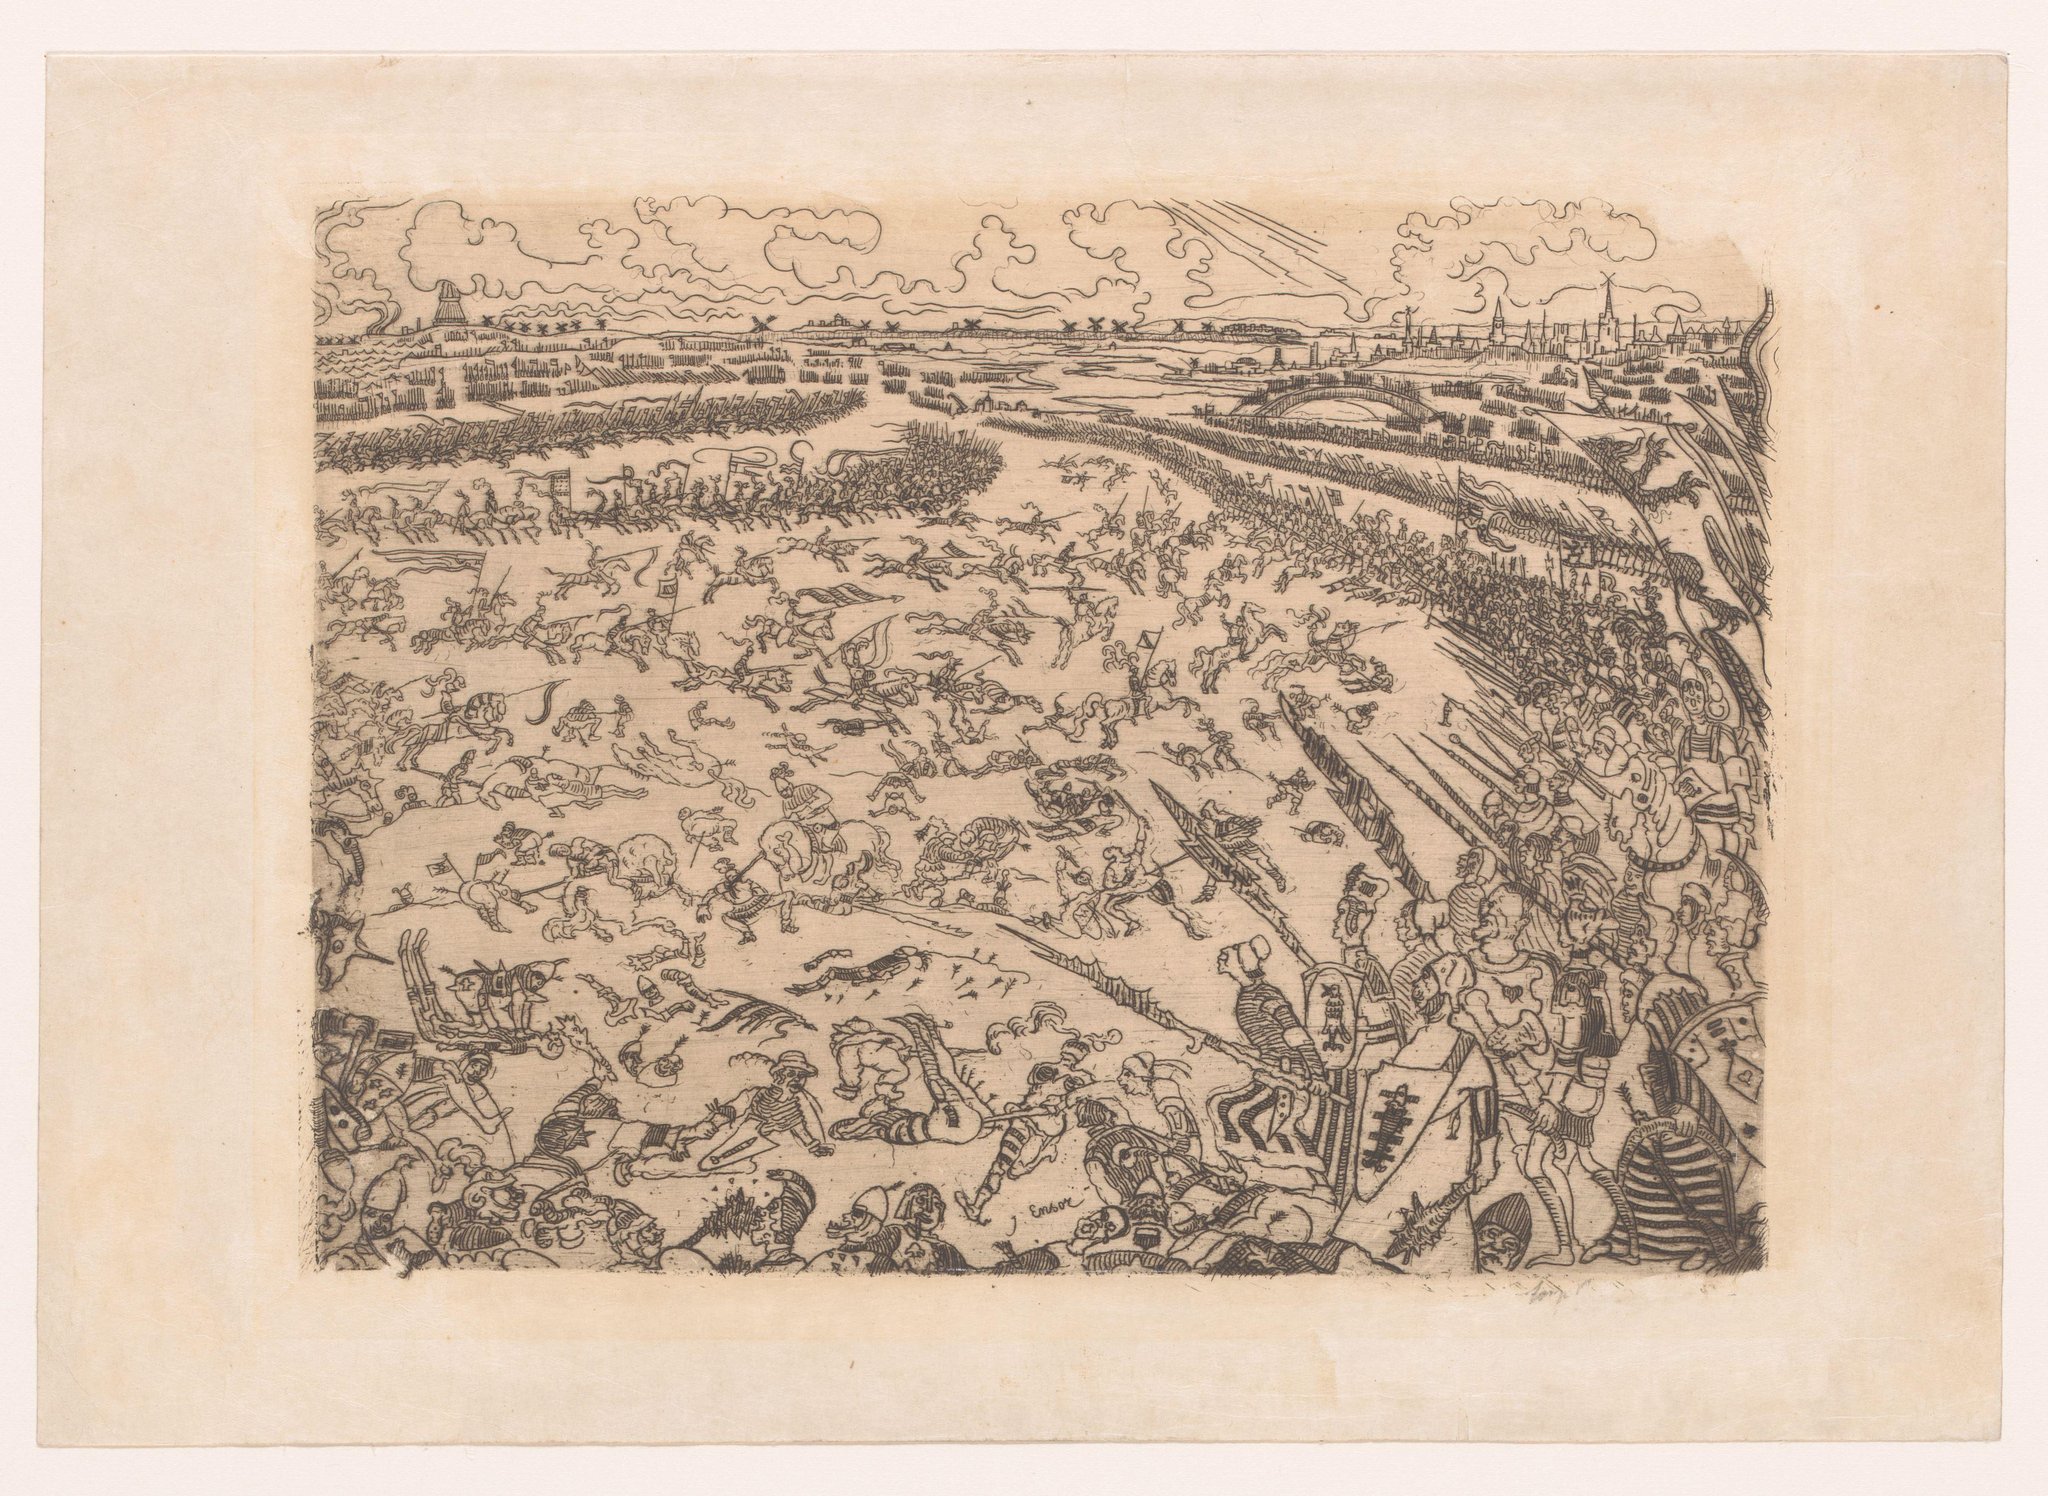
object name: print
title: Bataille des Eperons d'or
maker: james ensor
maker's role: print maker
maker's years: 1860-1949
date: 1895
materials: paper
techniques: etching, intaglio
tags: battle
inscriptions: collector's mark: Lugt 2228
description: De Guldensporenslag (Slag bij Kortrijk) vond plaats in 1302 tussen milities van het Graafschap Vlaanderen en Filips IV (koning van Frankrijk).